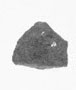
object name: shard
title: Shard (Study Collection)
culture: chinese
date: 1644-1911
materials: amber, ceramic, glaze